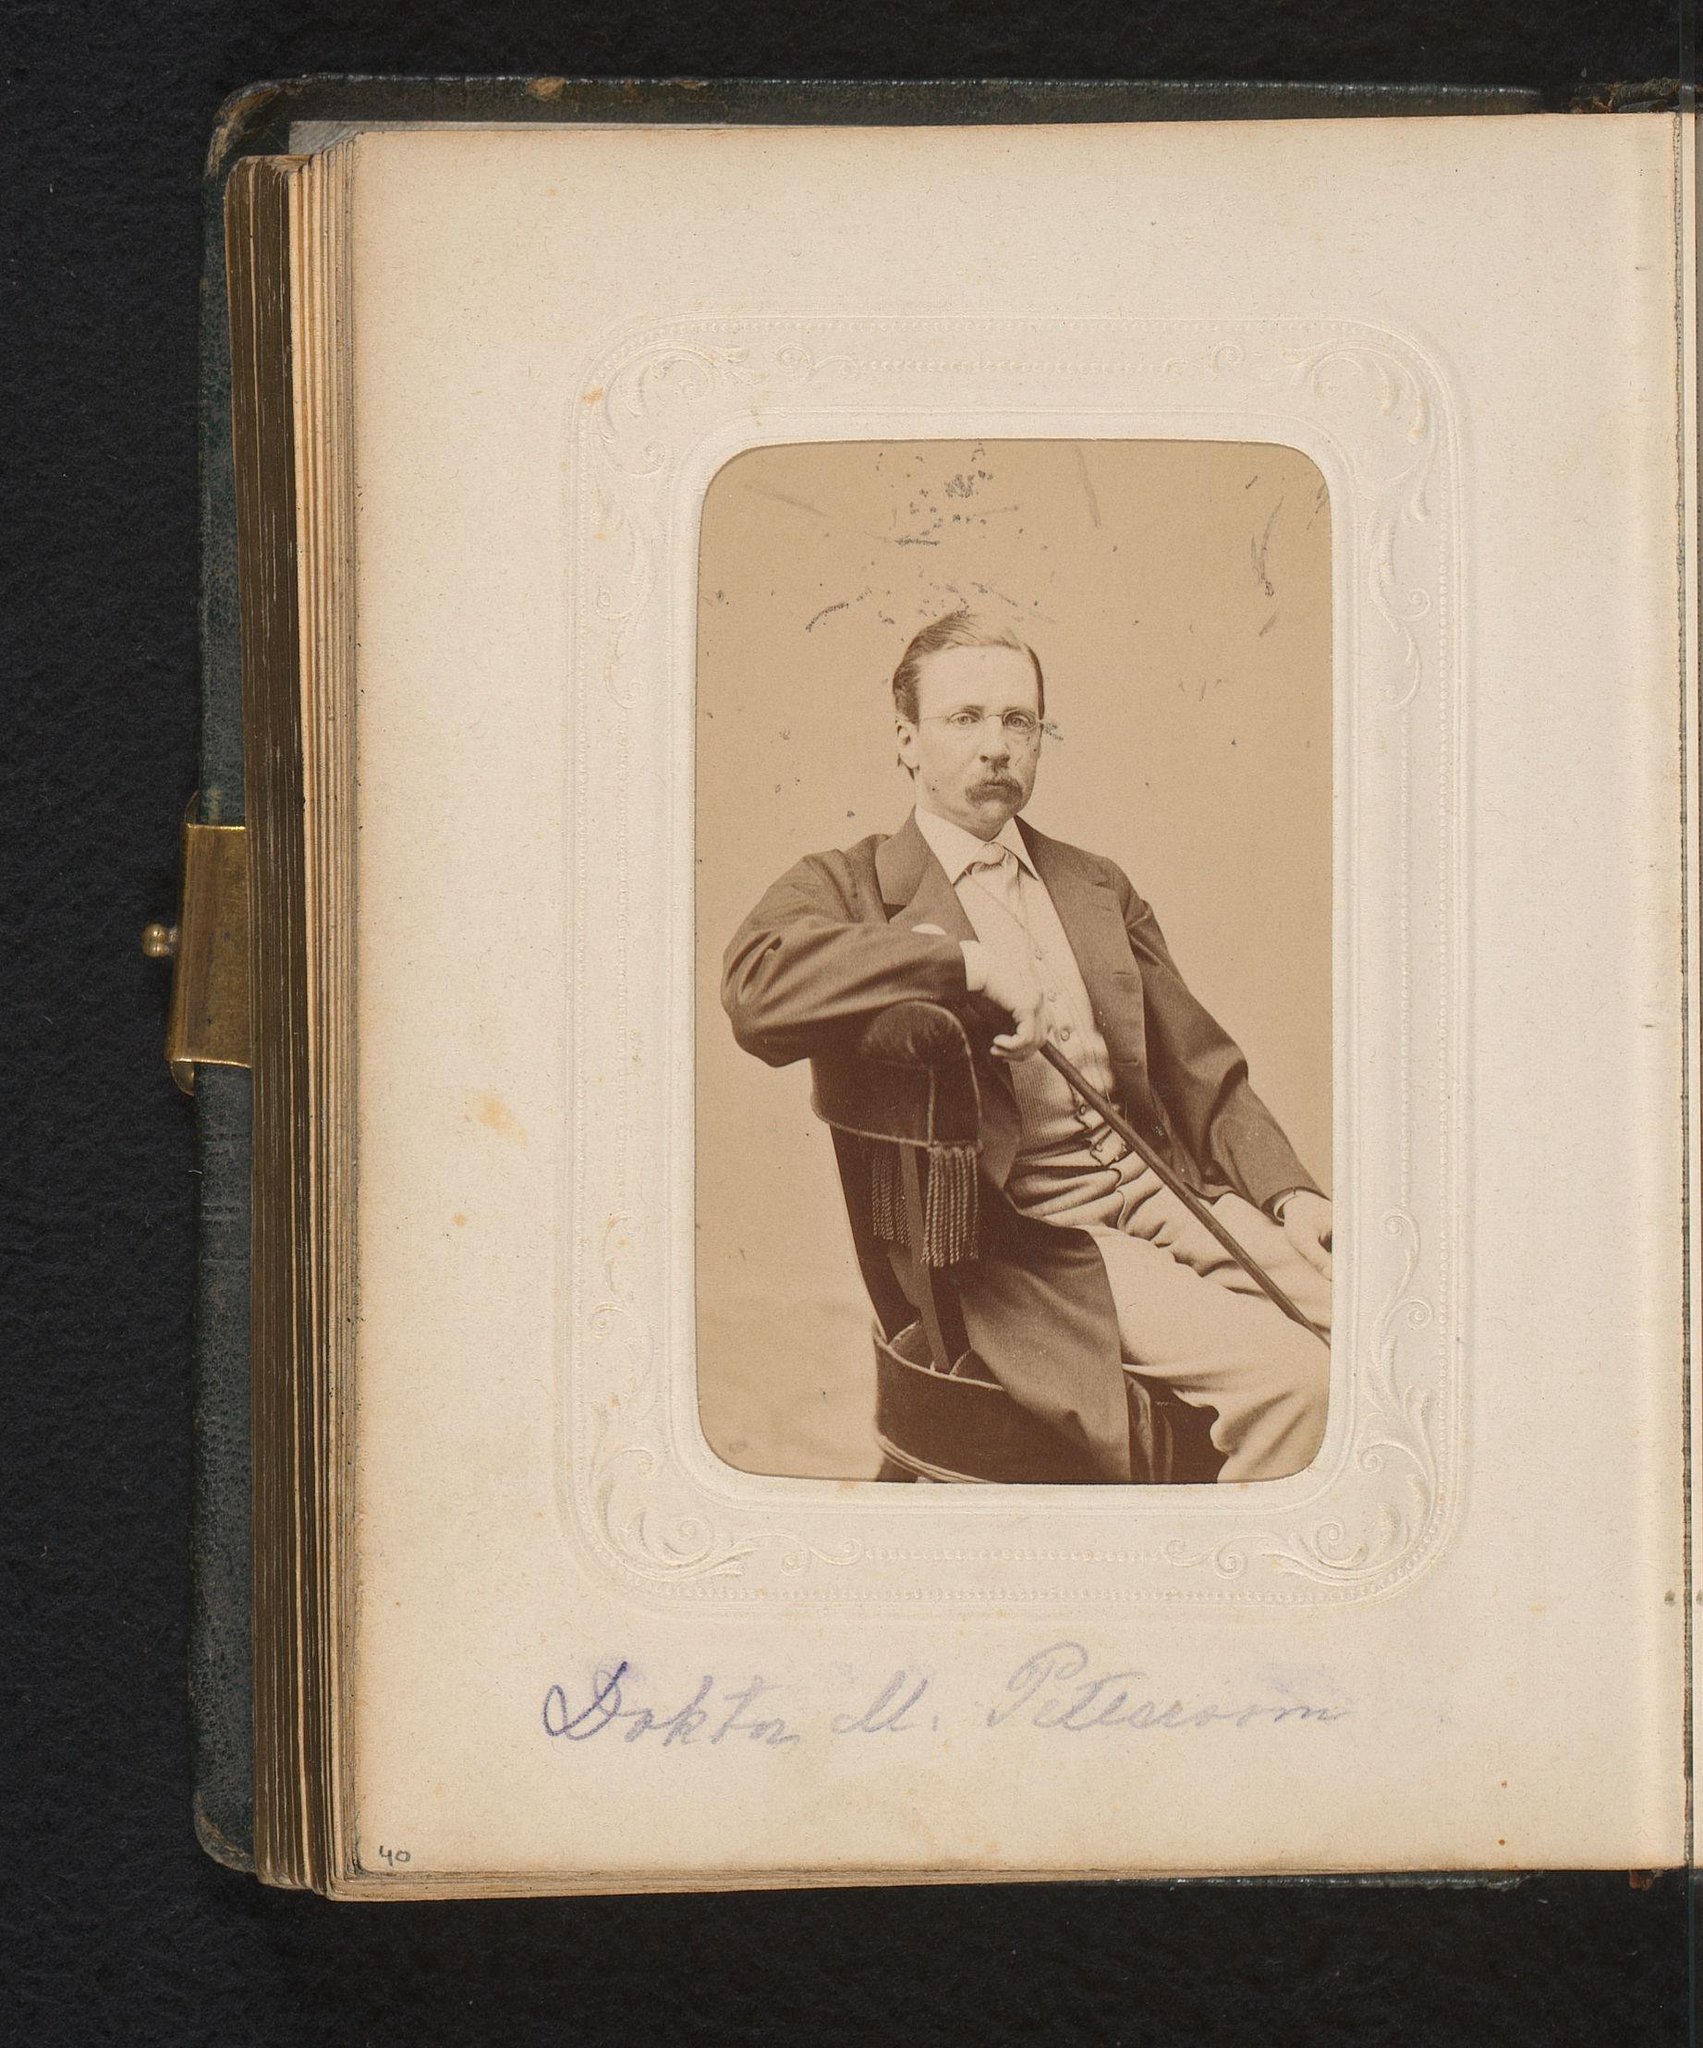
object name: photograph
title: Portret van een zittende man met wandelstok in de hand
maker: jacob lundbergh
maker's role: fotograaf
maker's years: 1828-1904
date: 1860-1900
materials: cardboard, photographic support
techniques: albumen print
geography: stockholm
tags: sitting figure, walking-stick, staff, historical persons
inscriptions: inscription: ‘B. J. LUNDBERGH./ Stockholm & Söder/ Urwadersgrand N4’, name: ‘Doktor M. Petes[...]m’